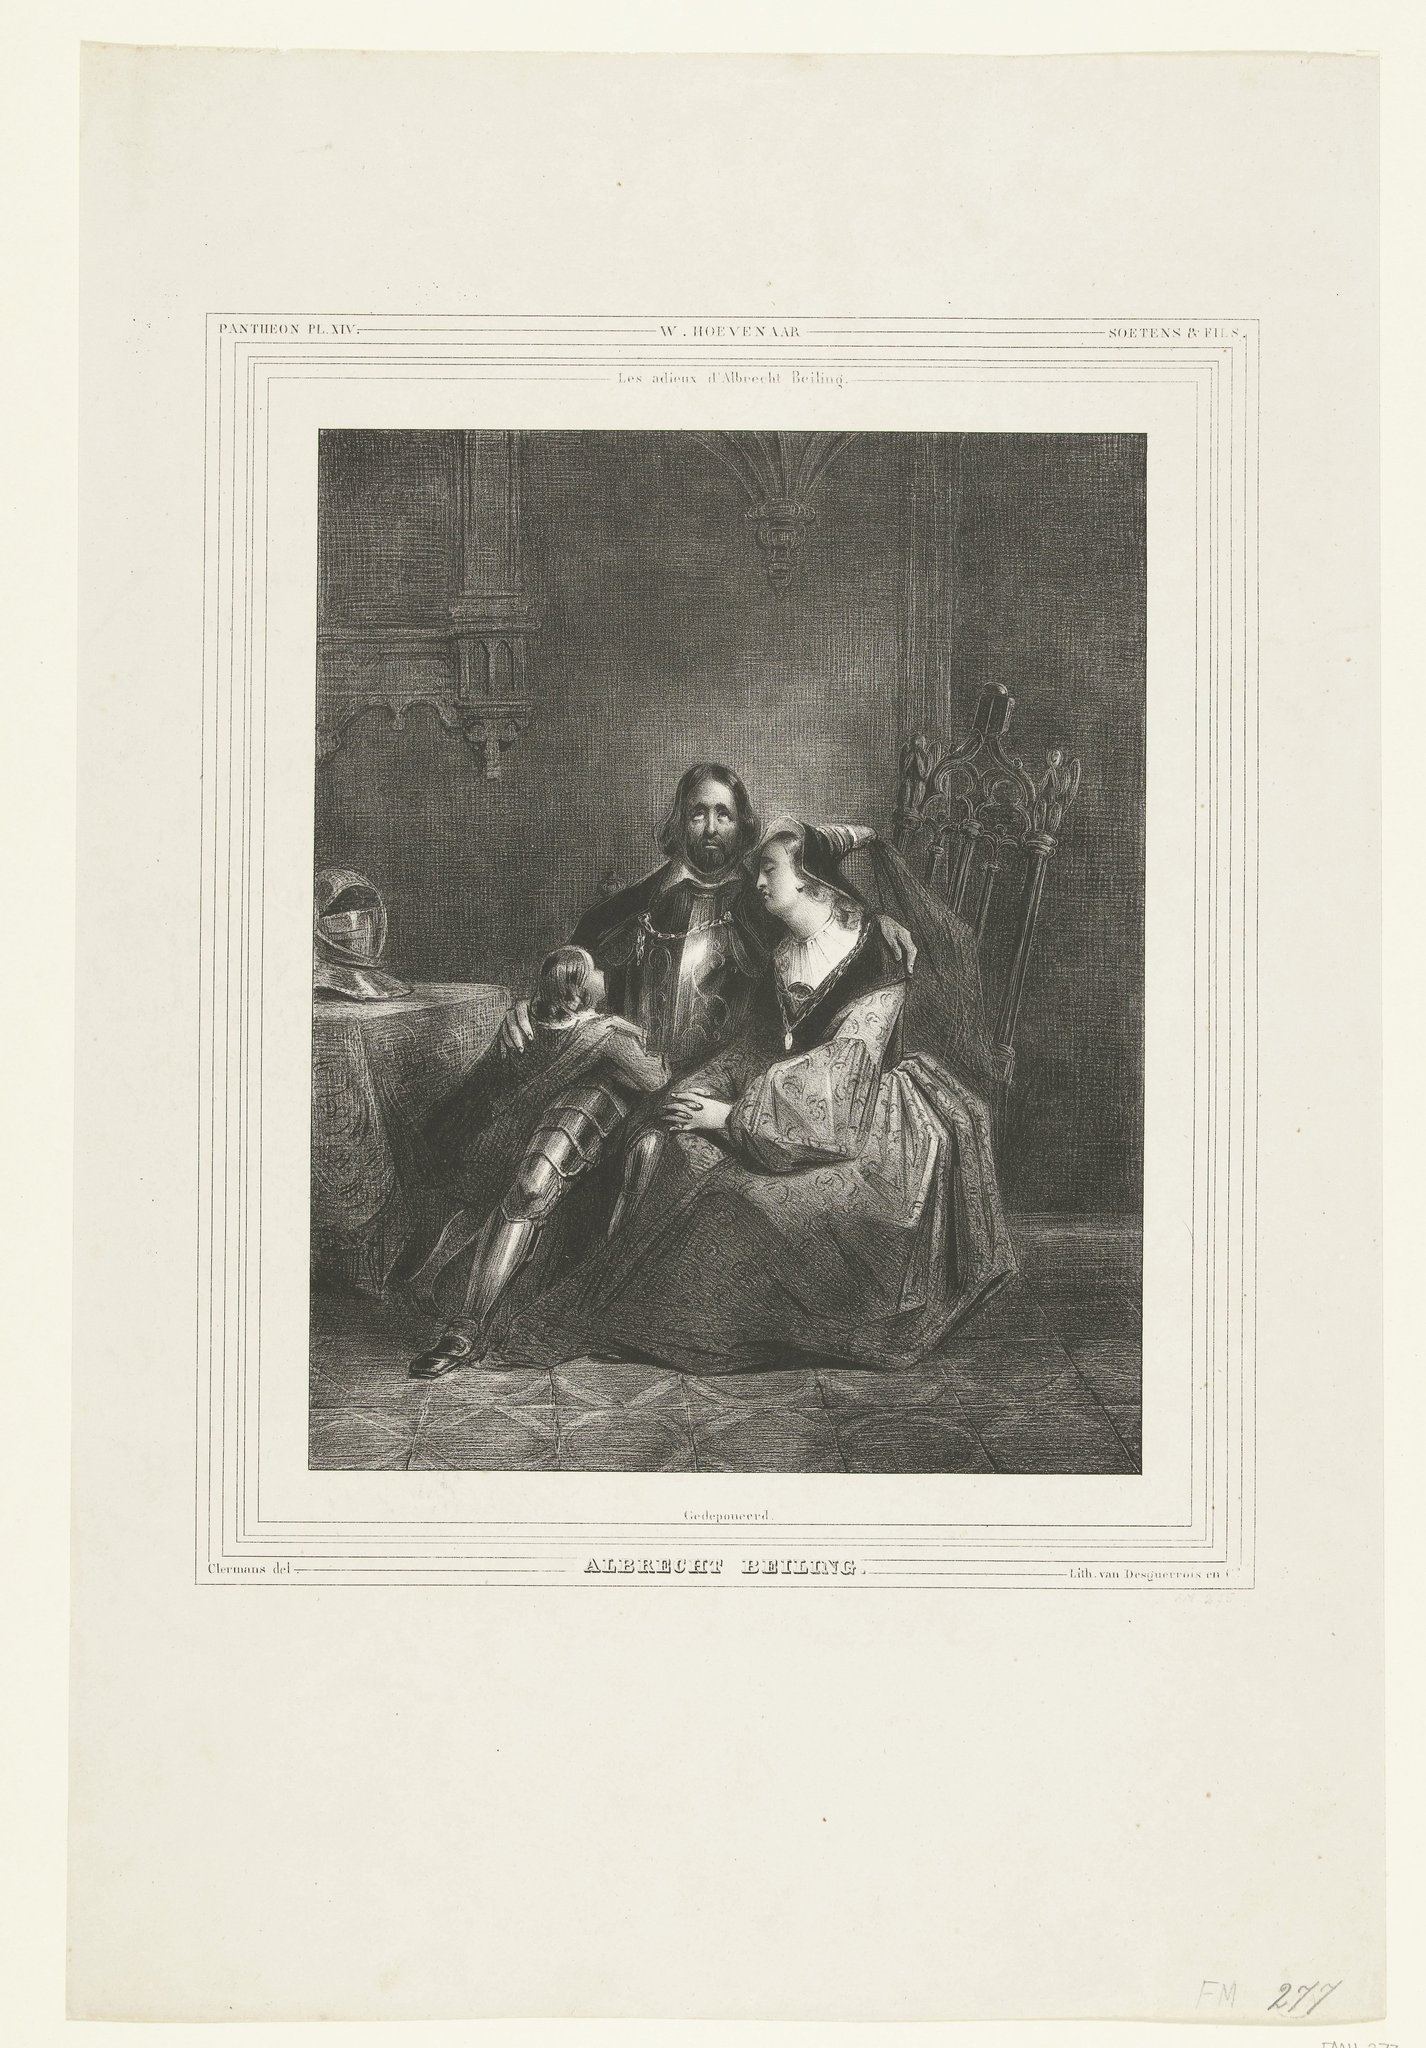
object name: print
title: Albrecht Beiling neemt afscheid van vrouw en kind, 1426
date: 1837-1840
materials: paper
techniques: lithograph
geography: netherlands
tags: jacoba of bavaria (countess of hainaut), on the scaffold or place of execution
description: Albrecht Beiling, bevelhebber in Schoonhoven, door Jacoba van Beieren veroordeeld om levend begraven te worden, neemt afscheid van vrouw en kind, januari 1426.